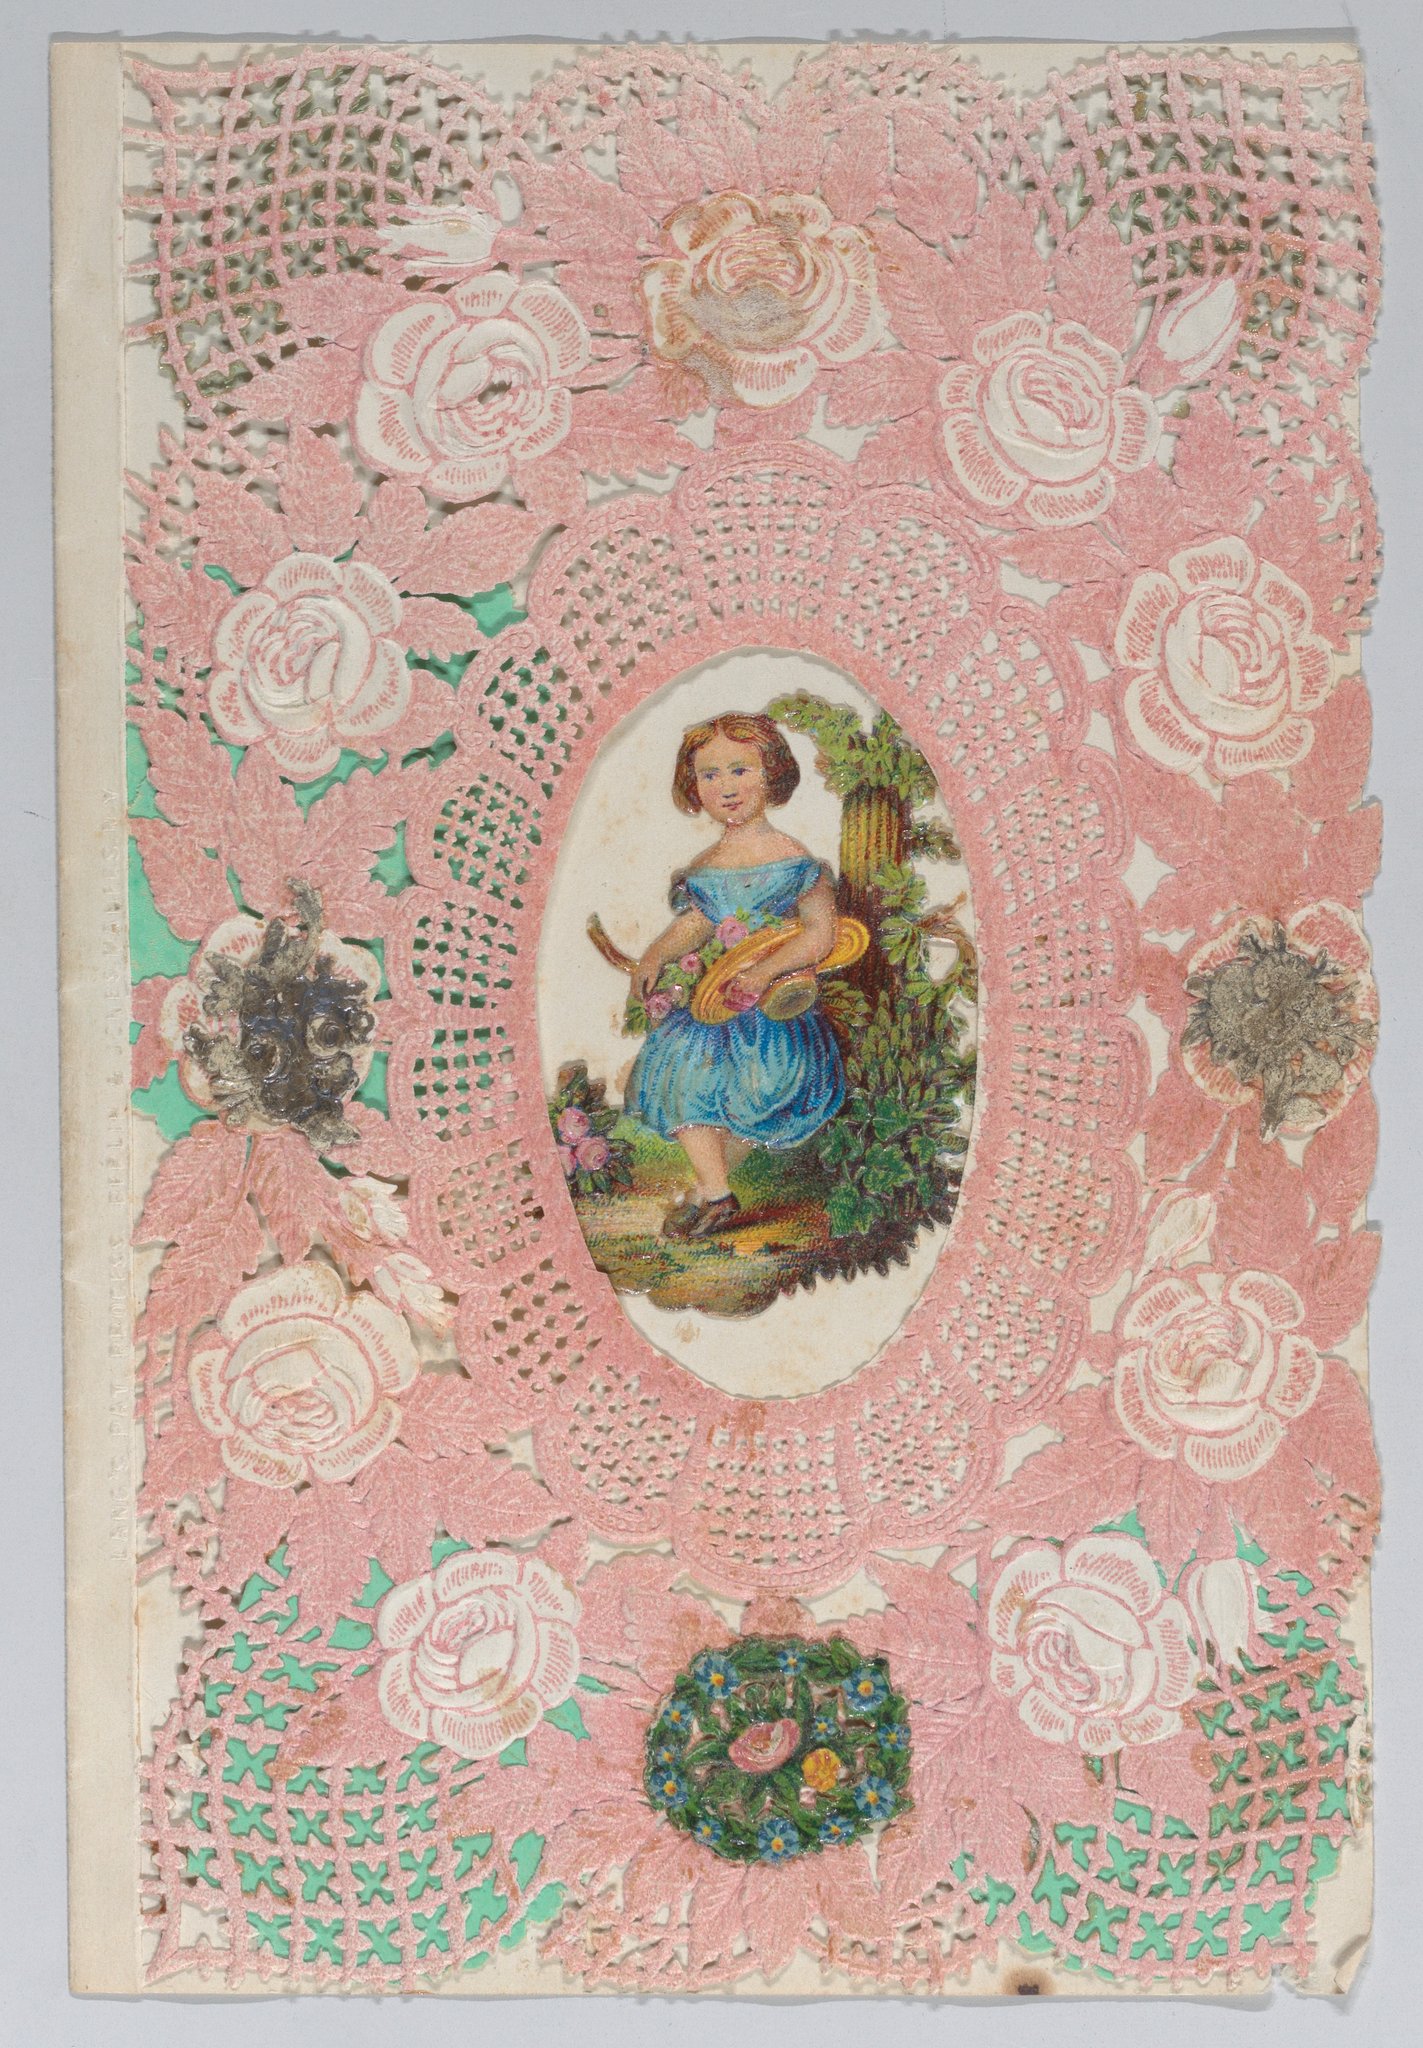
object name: valentine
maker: Anonymous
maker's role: artist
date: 1880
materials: lace, paper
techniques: cutting, embossing, open work